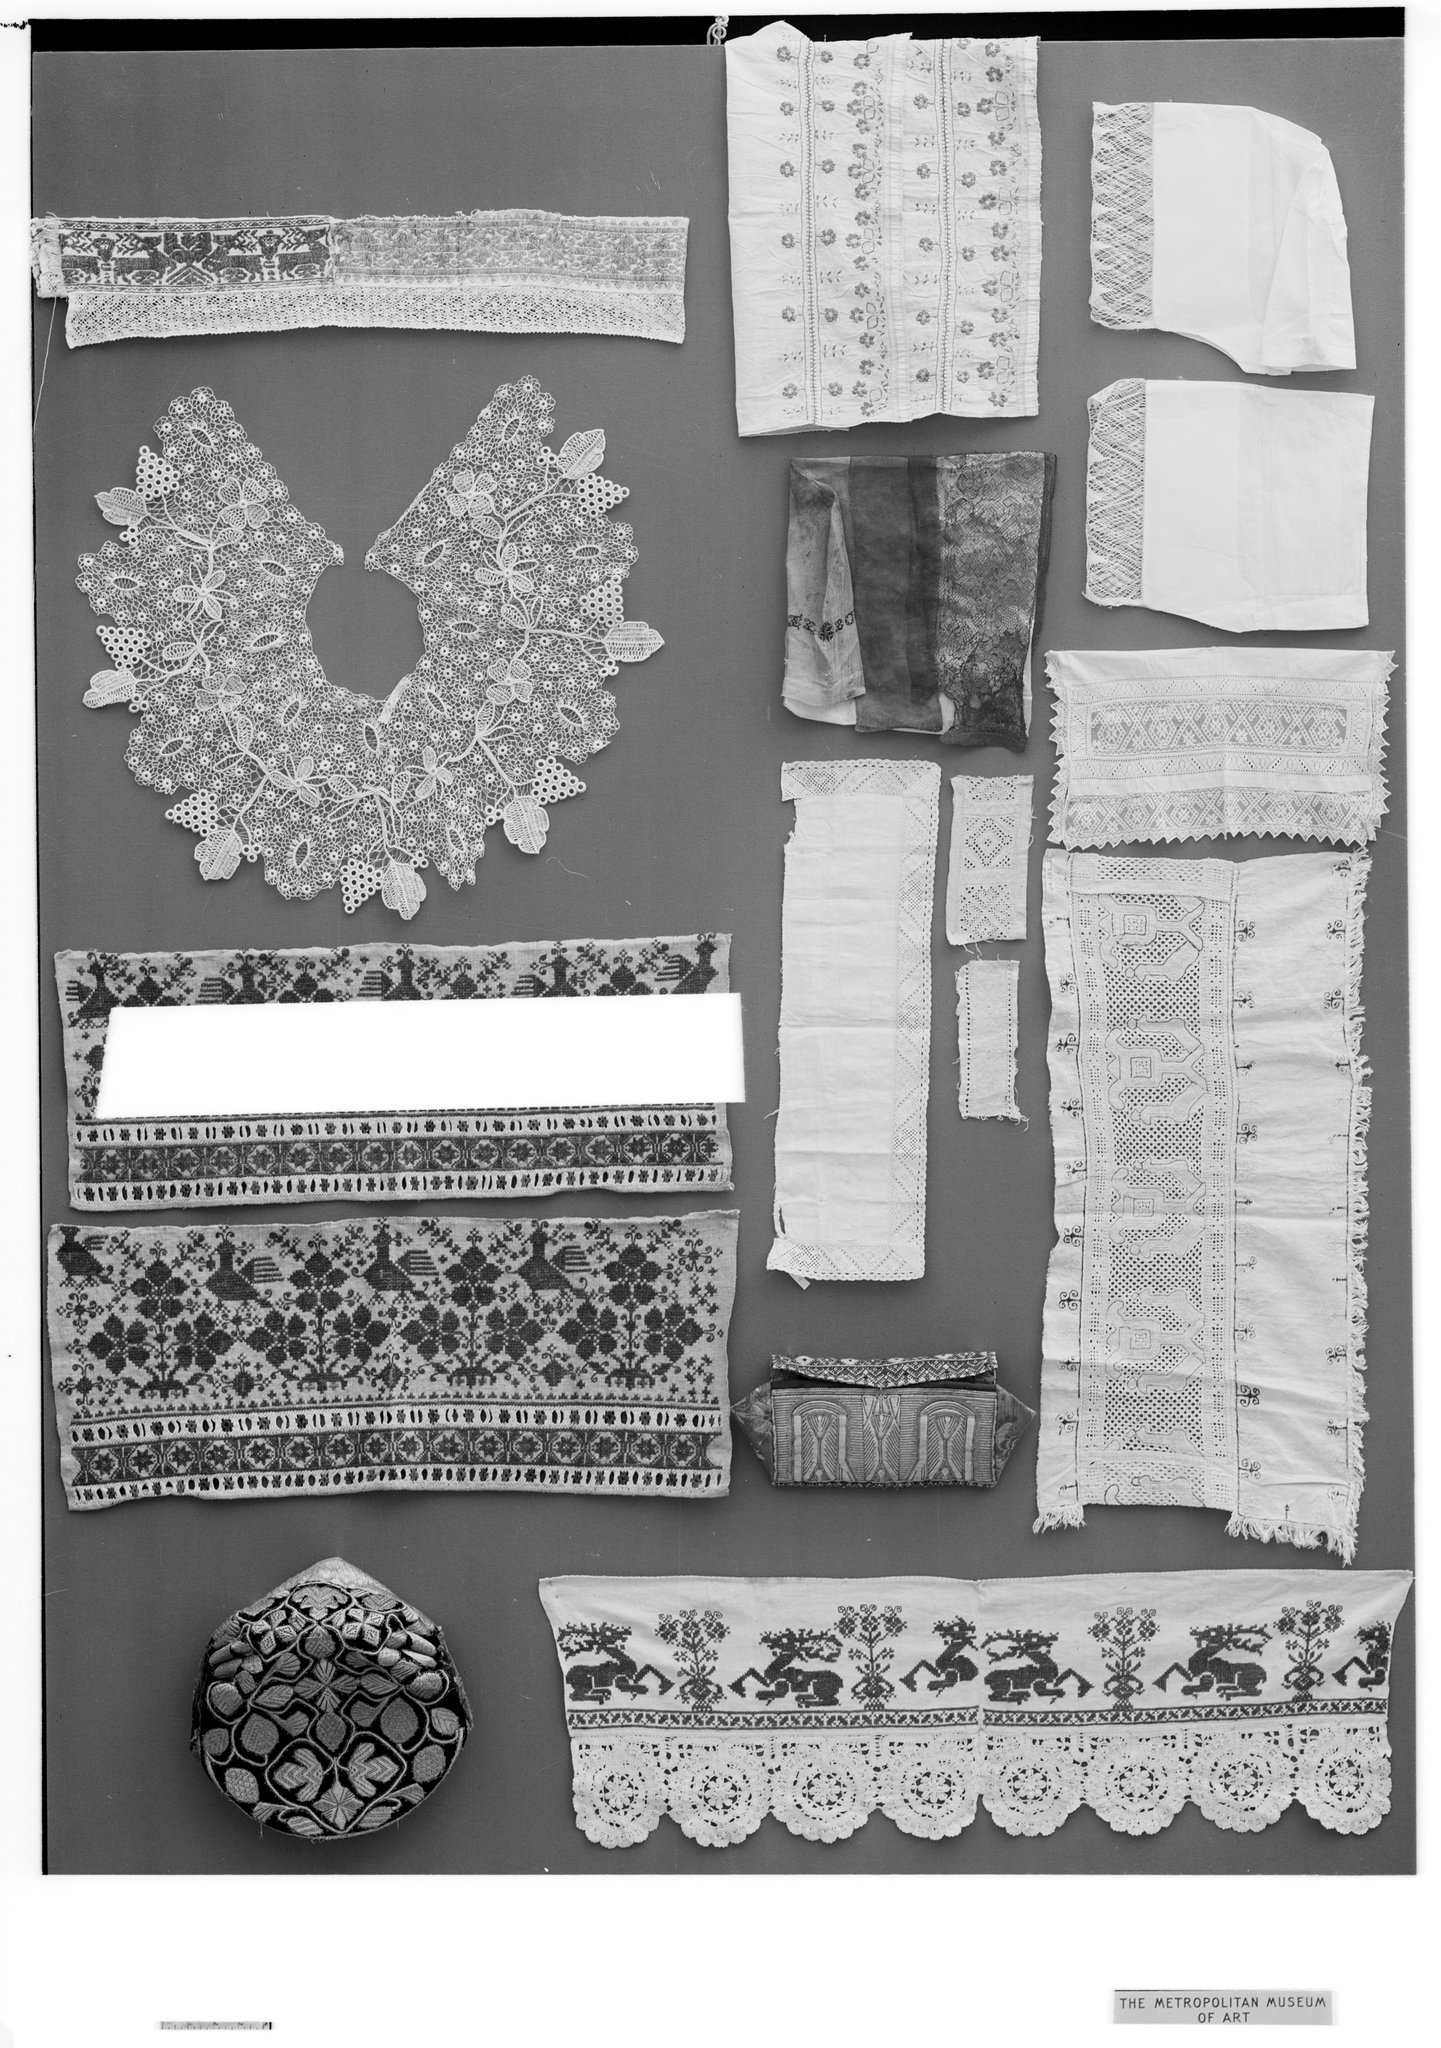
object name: band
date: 1701-1800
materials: linen